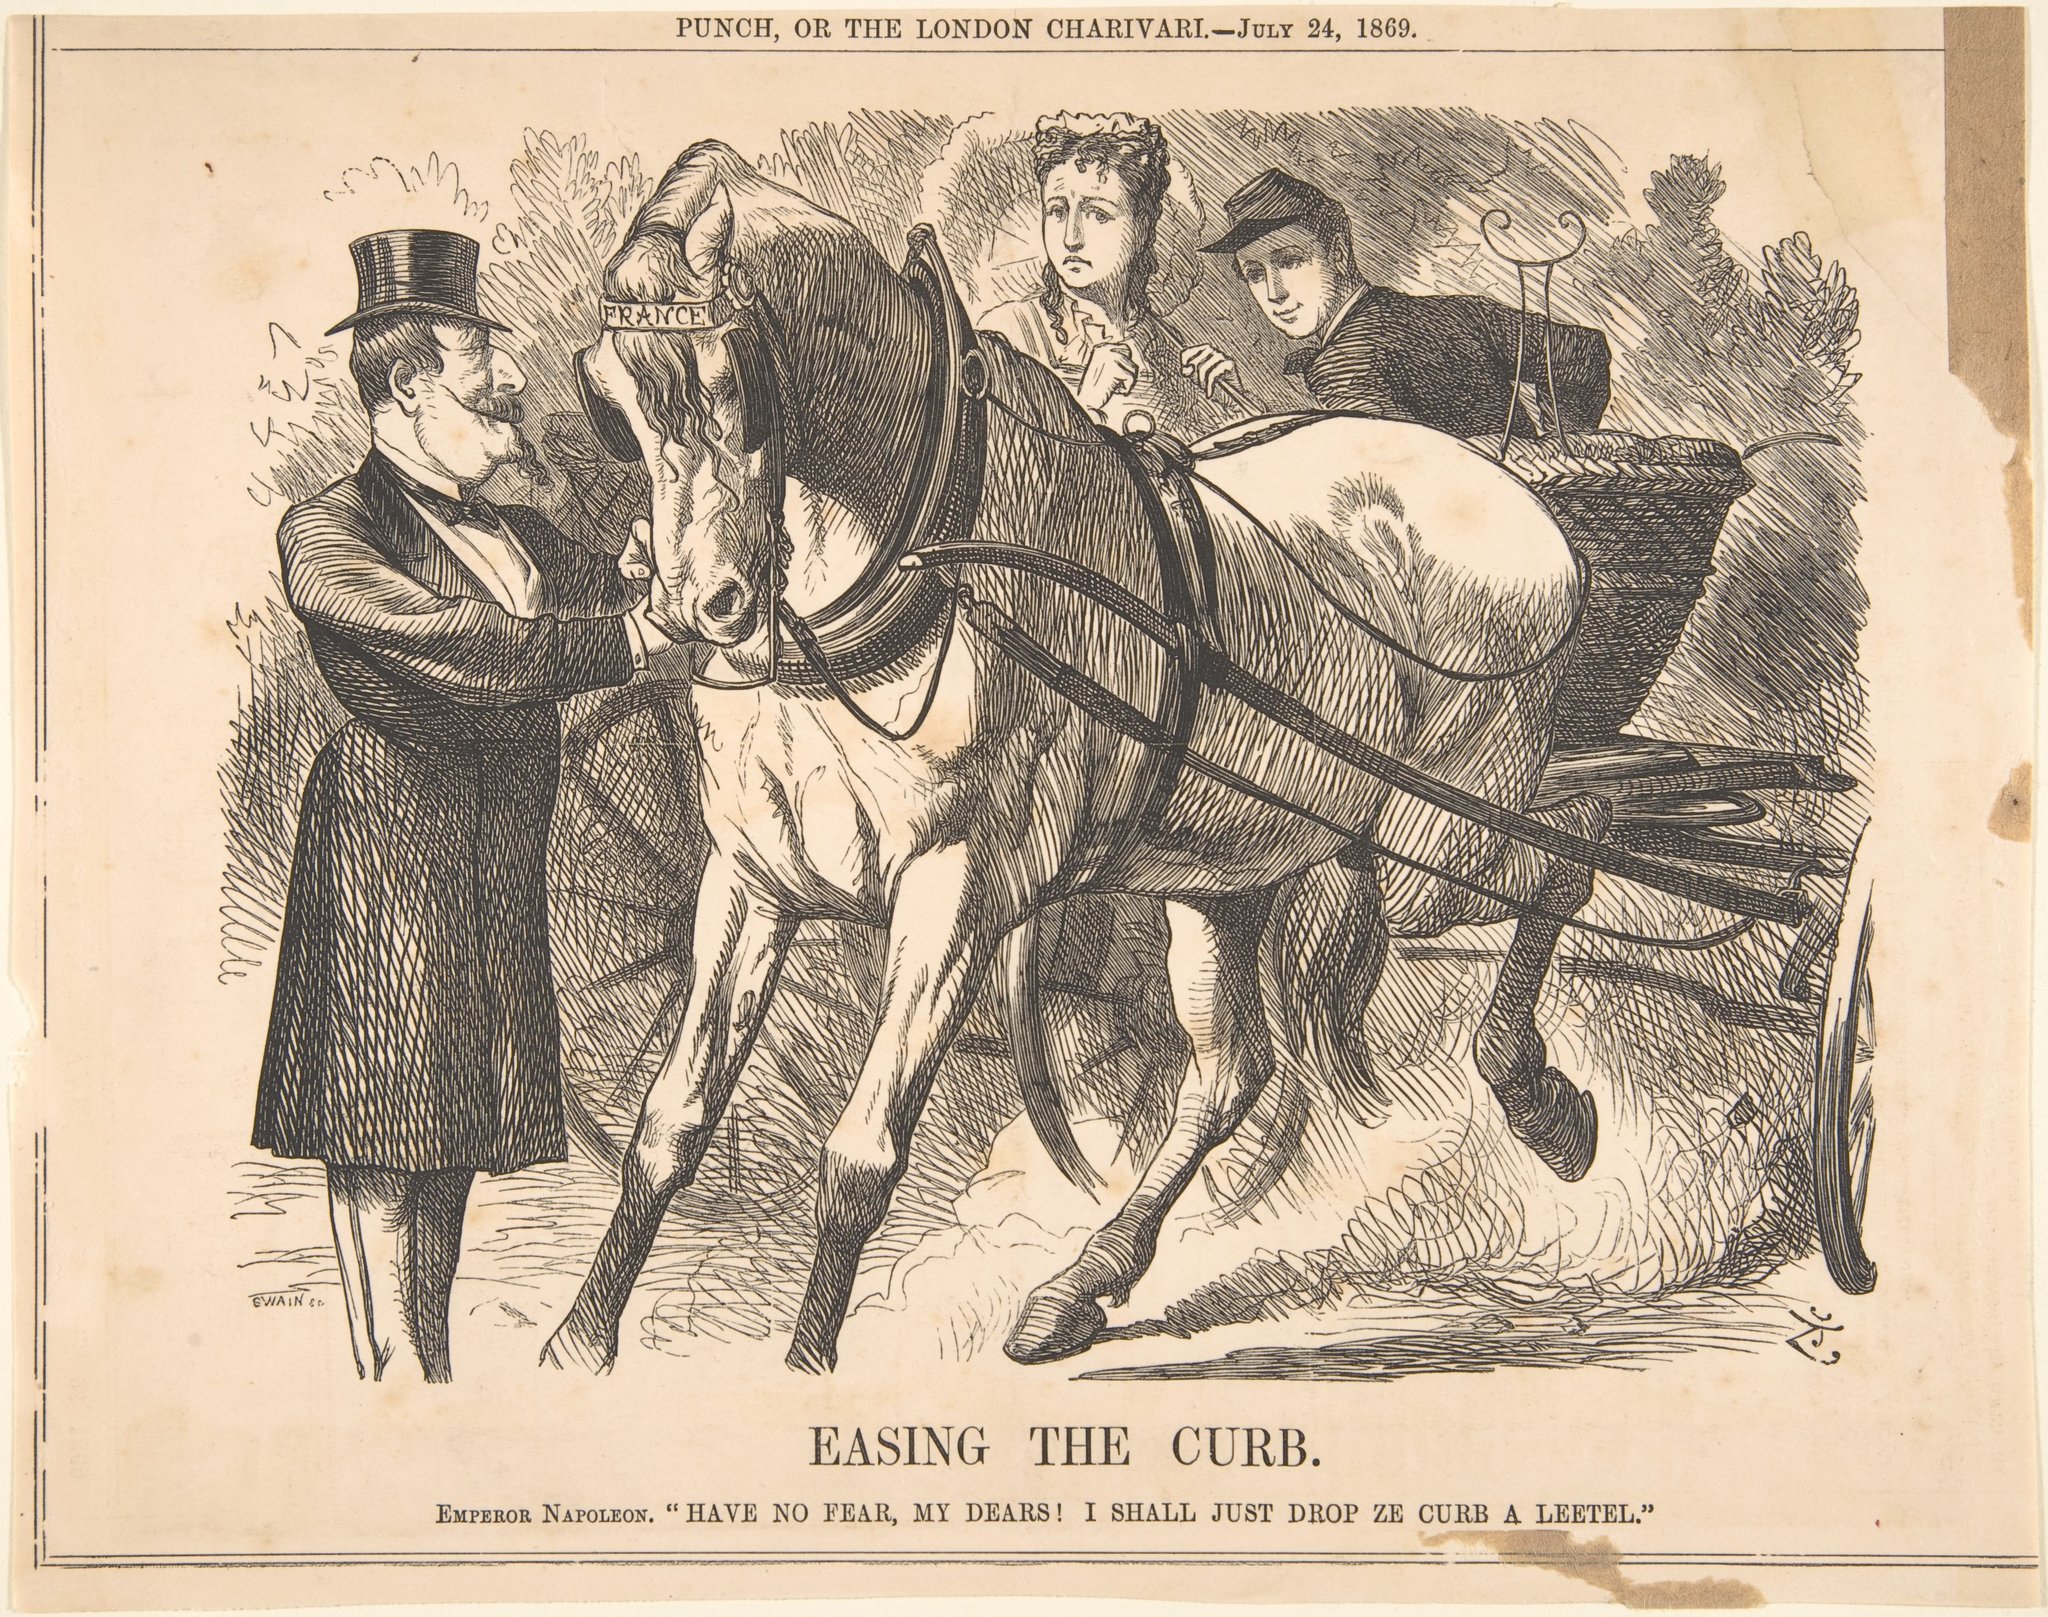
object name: print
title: Easing the Curb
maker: sir john tenniel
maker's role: artist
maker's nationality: british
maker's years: 1820-1914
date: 1869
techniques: engraving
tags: men,women,horses,carriages